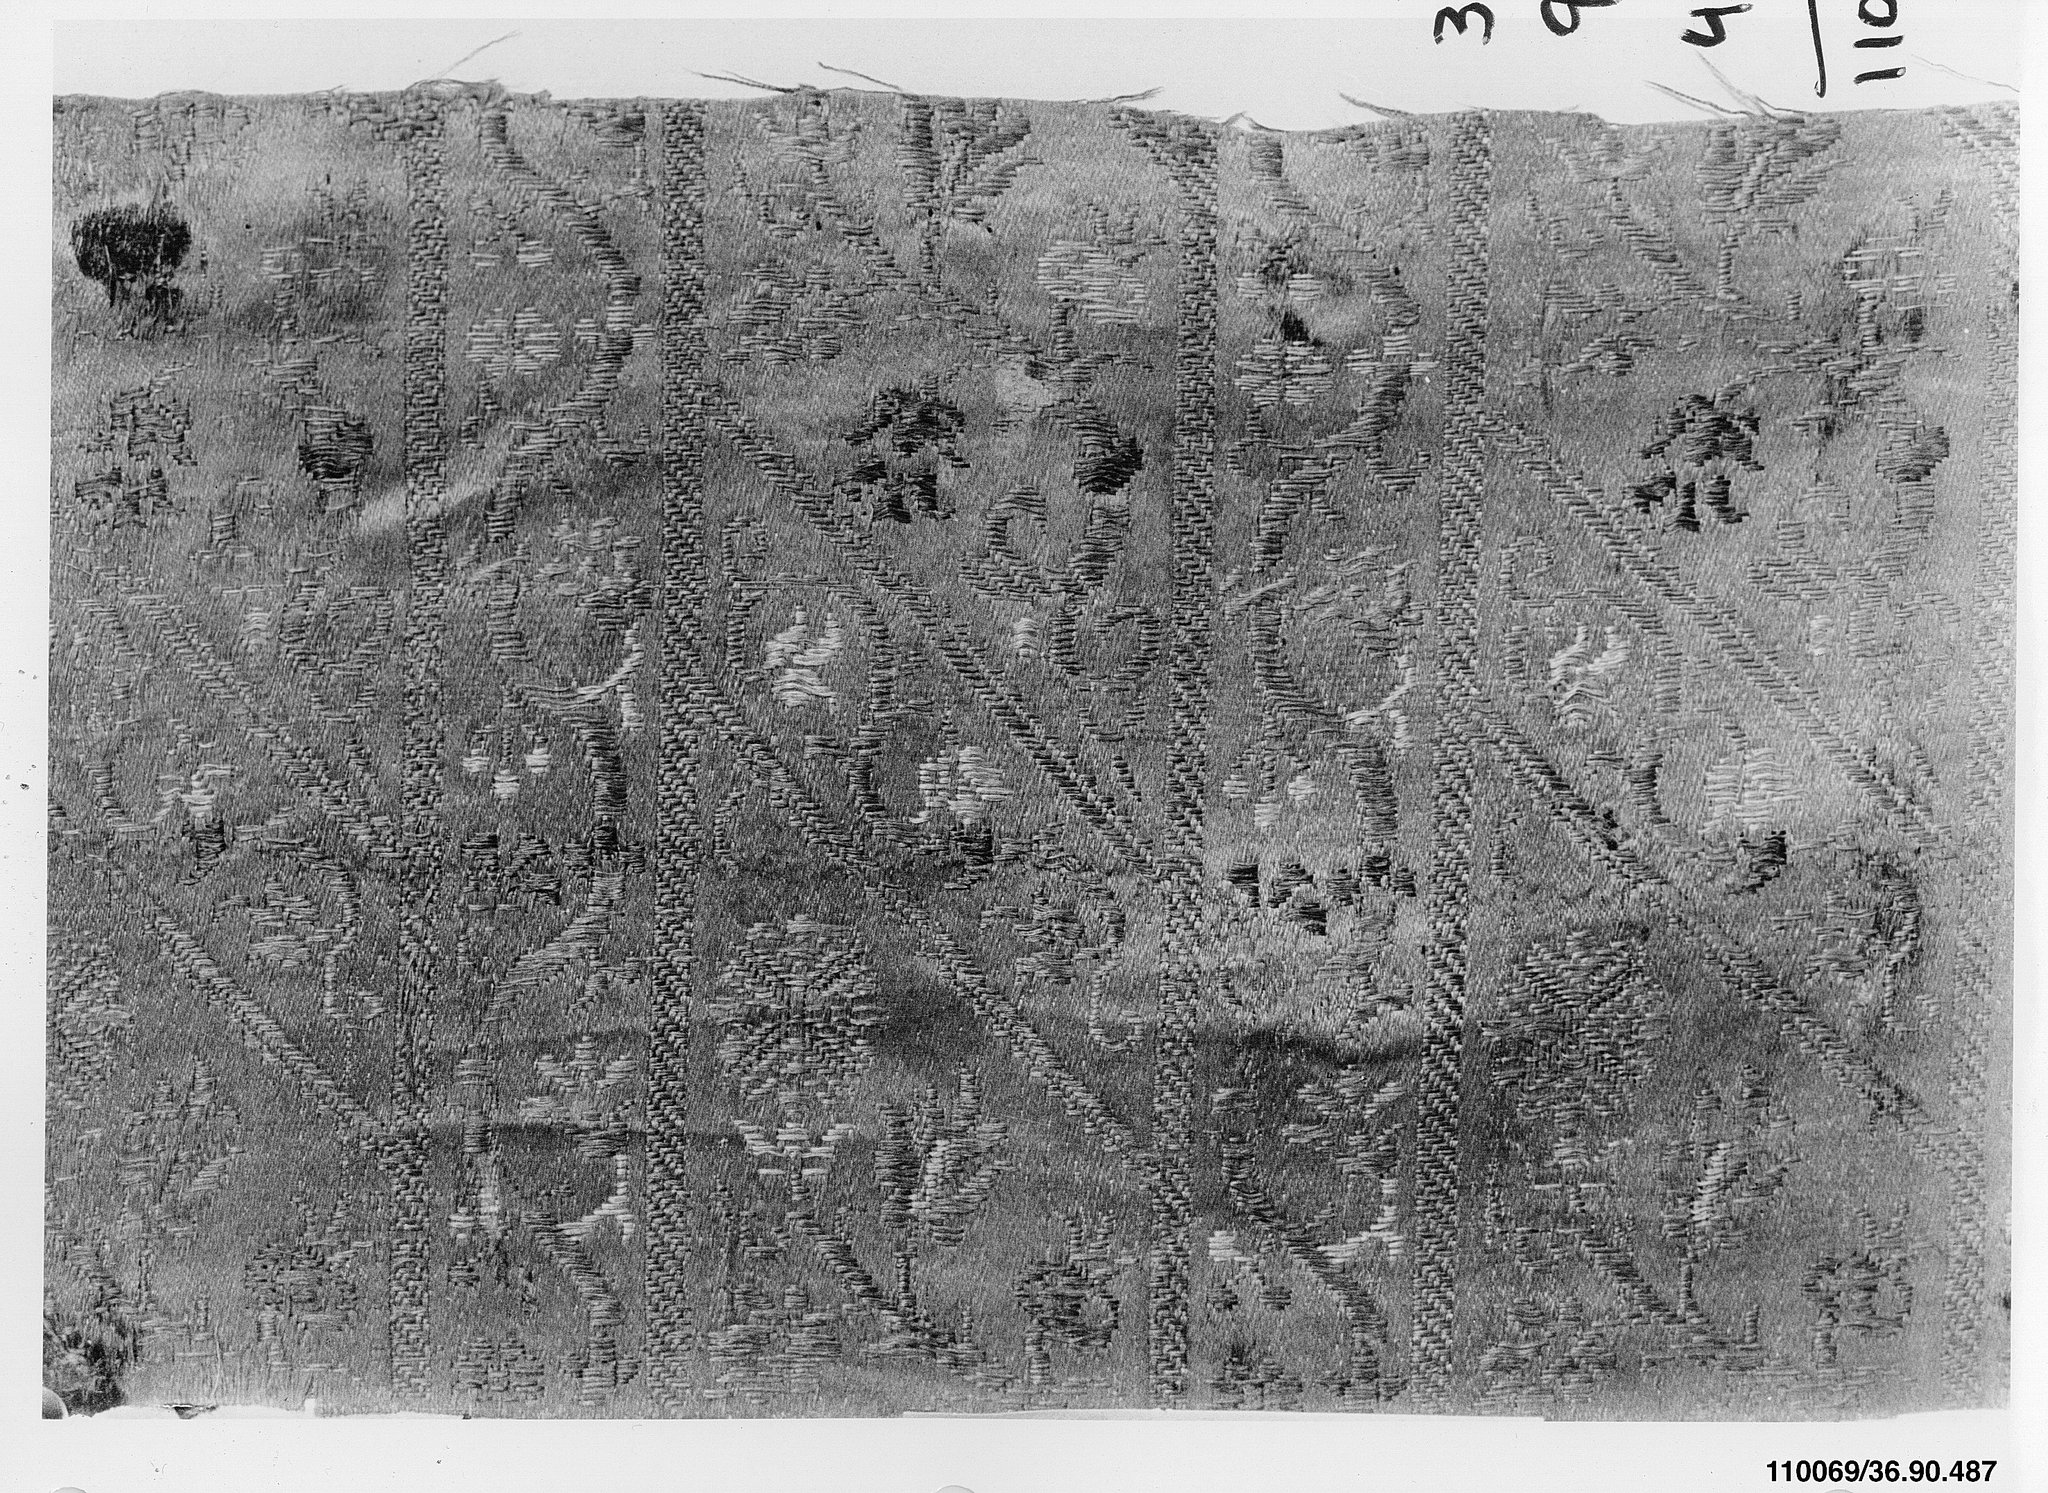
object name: piece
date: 1501-1700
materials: silk